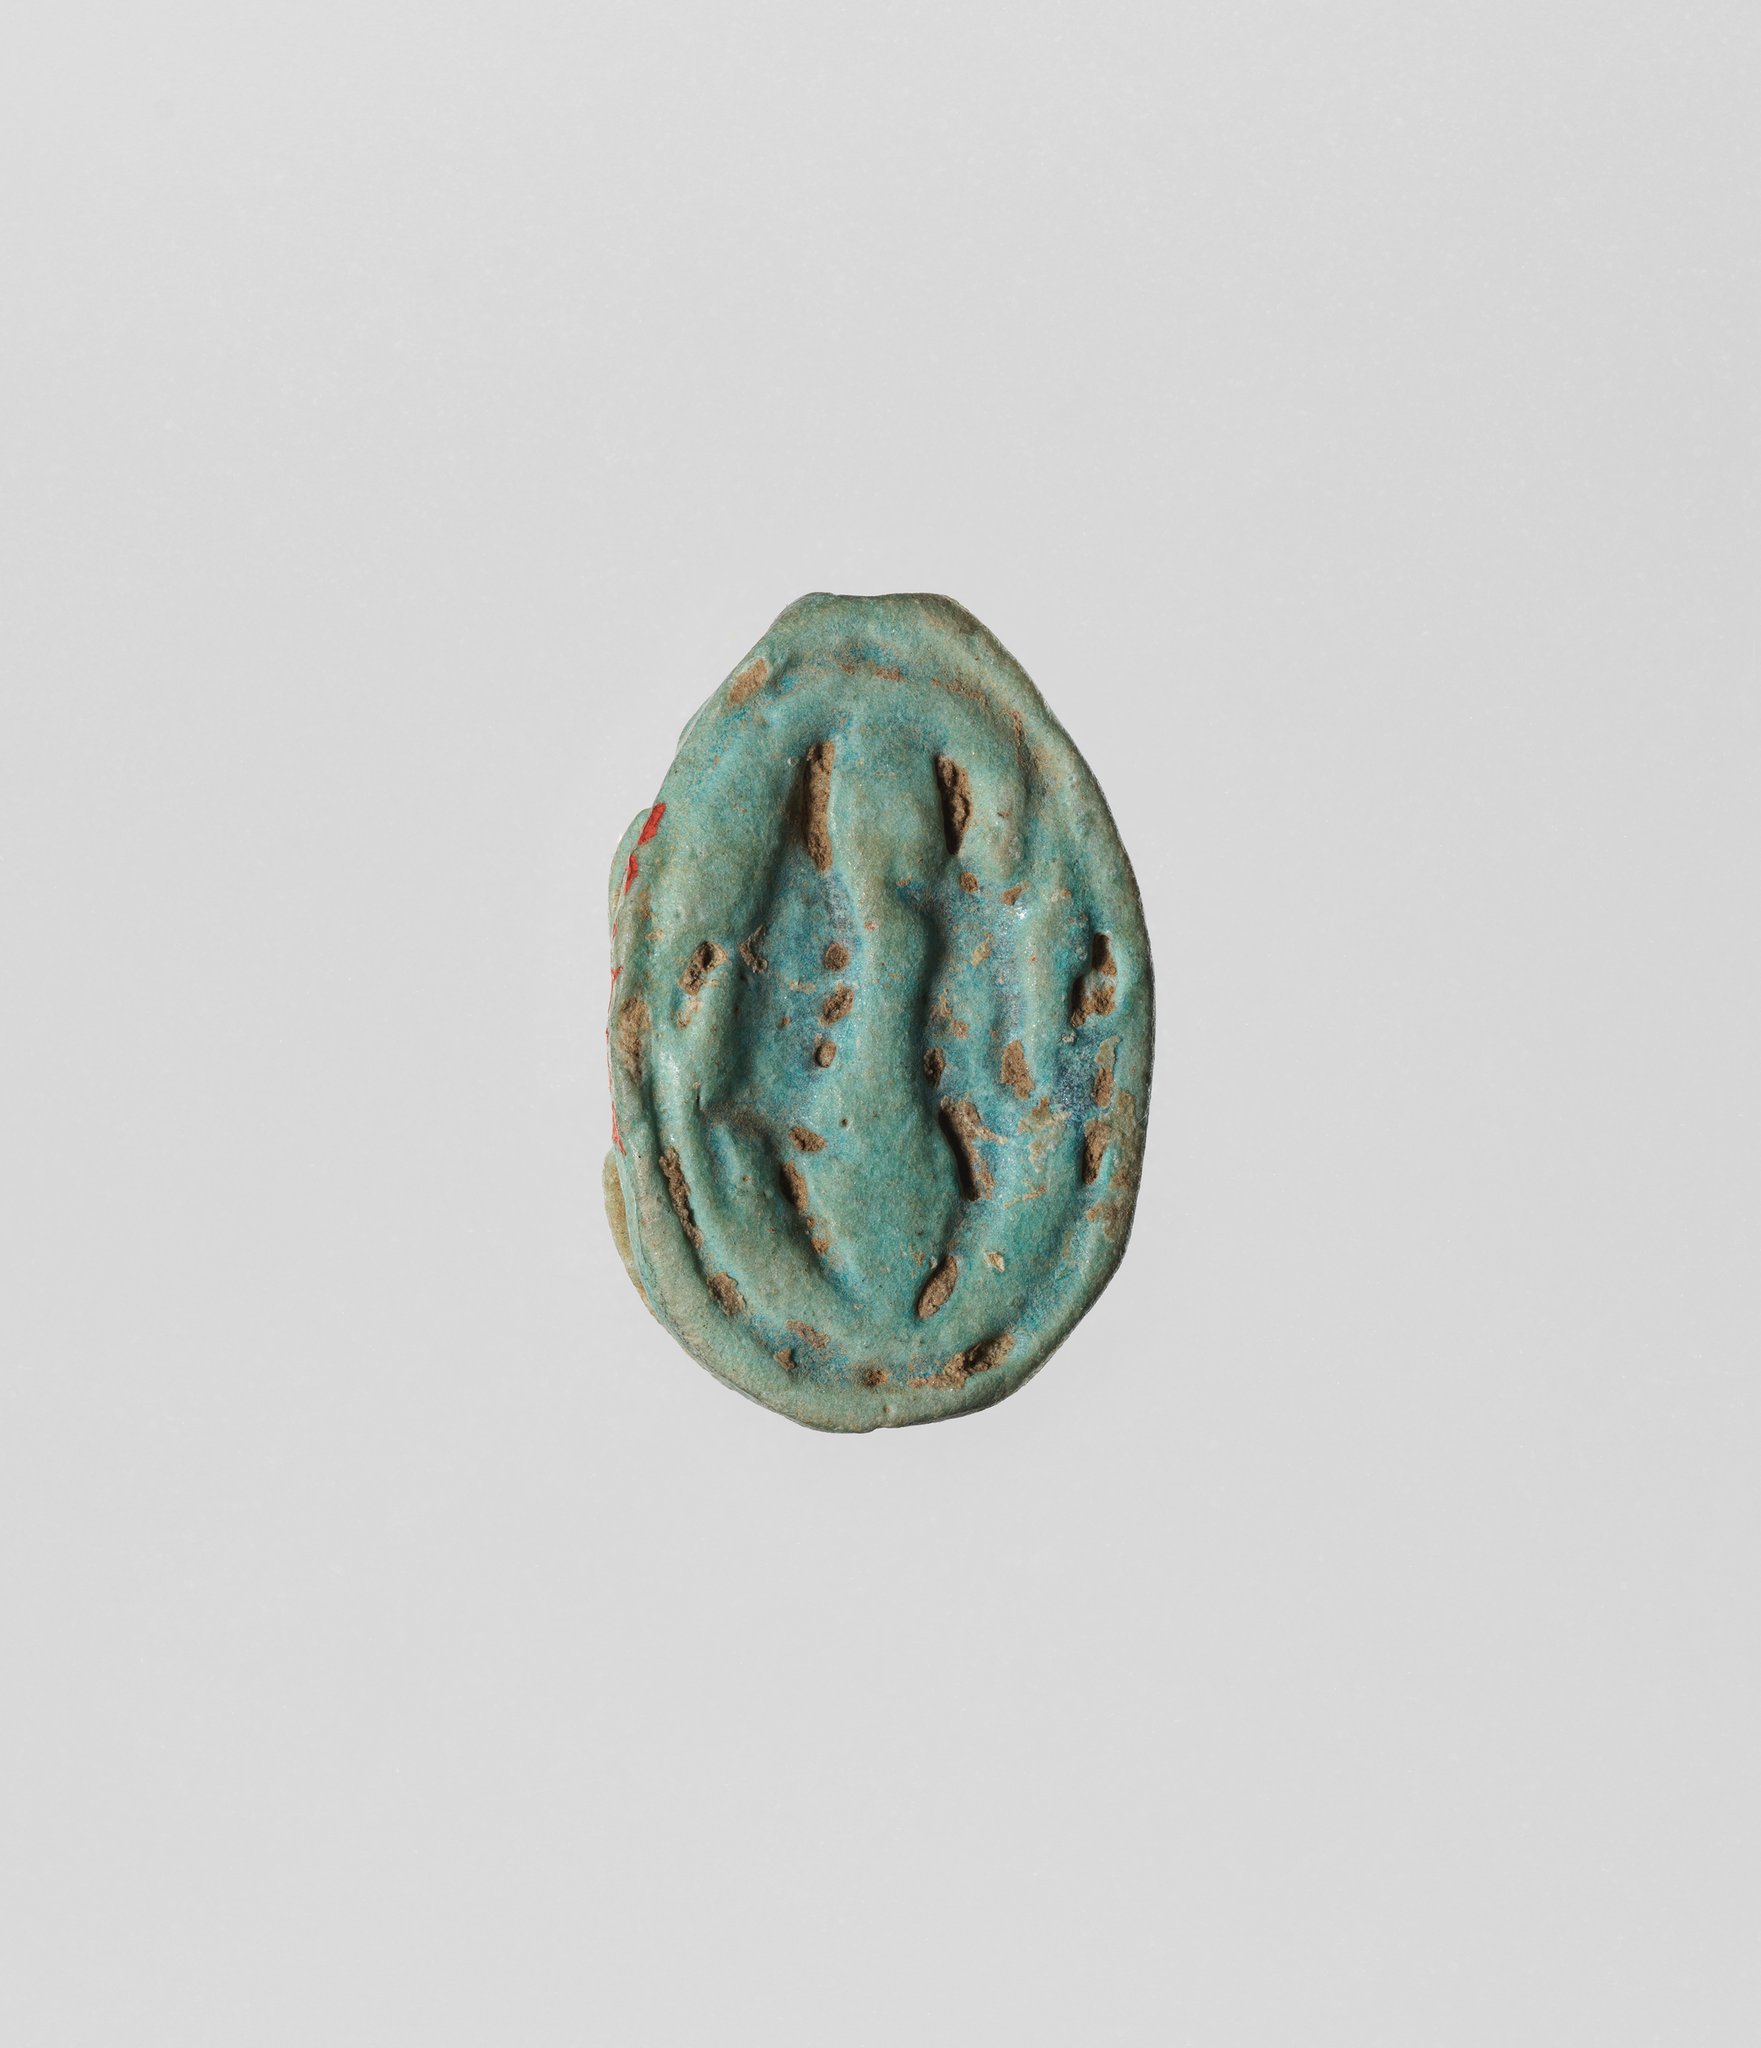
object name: scarab, crocodile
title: Scarab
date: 750-300 BCE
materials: faience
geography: nubia